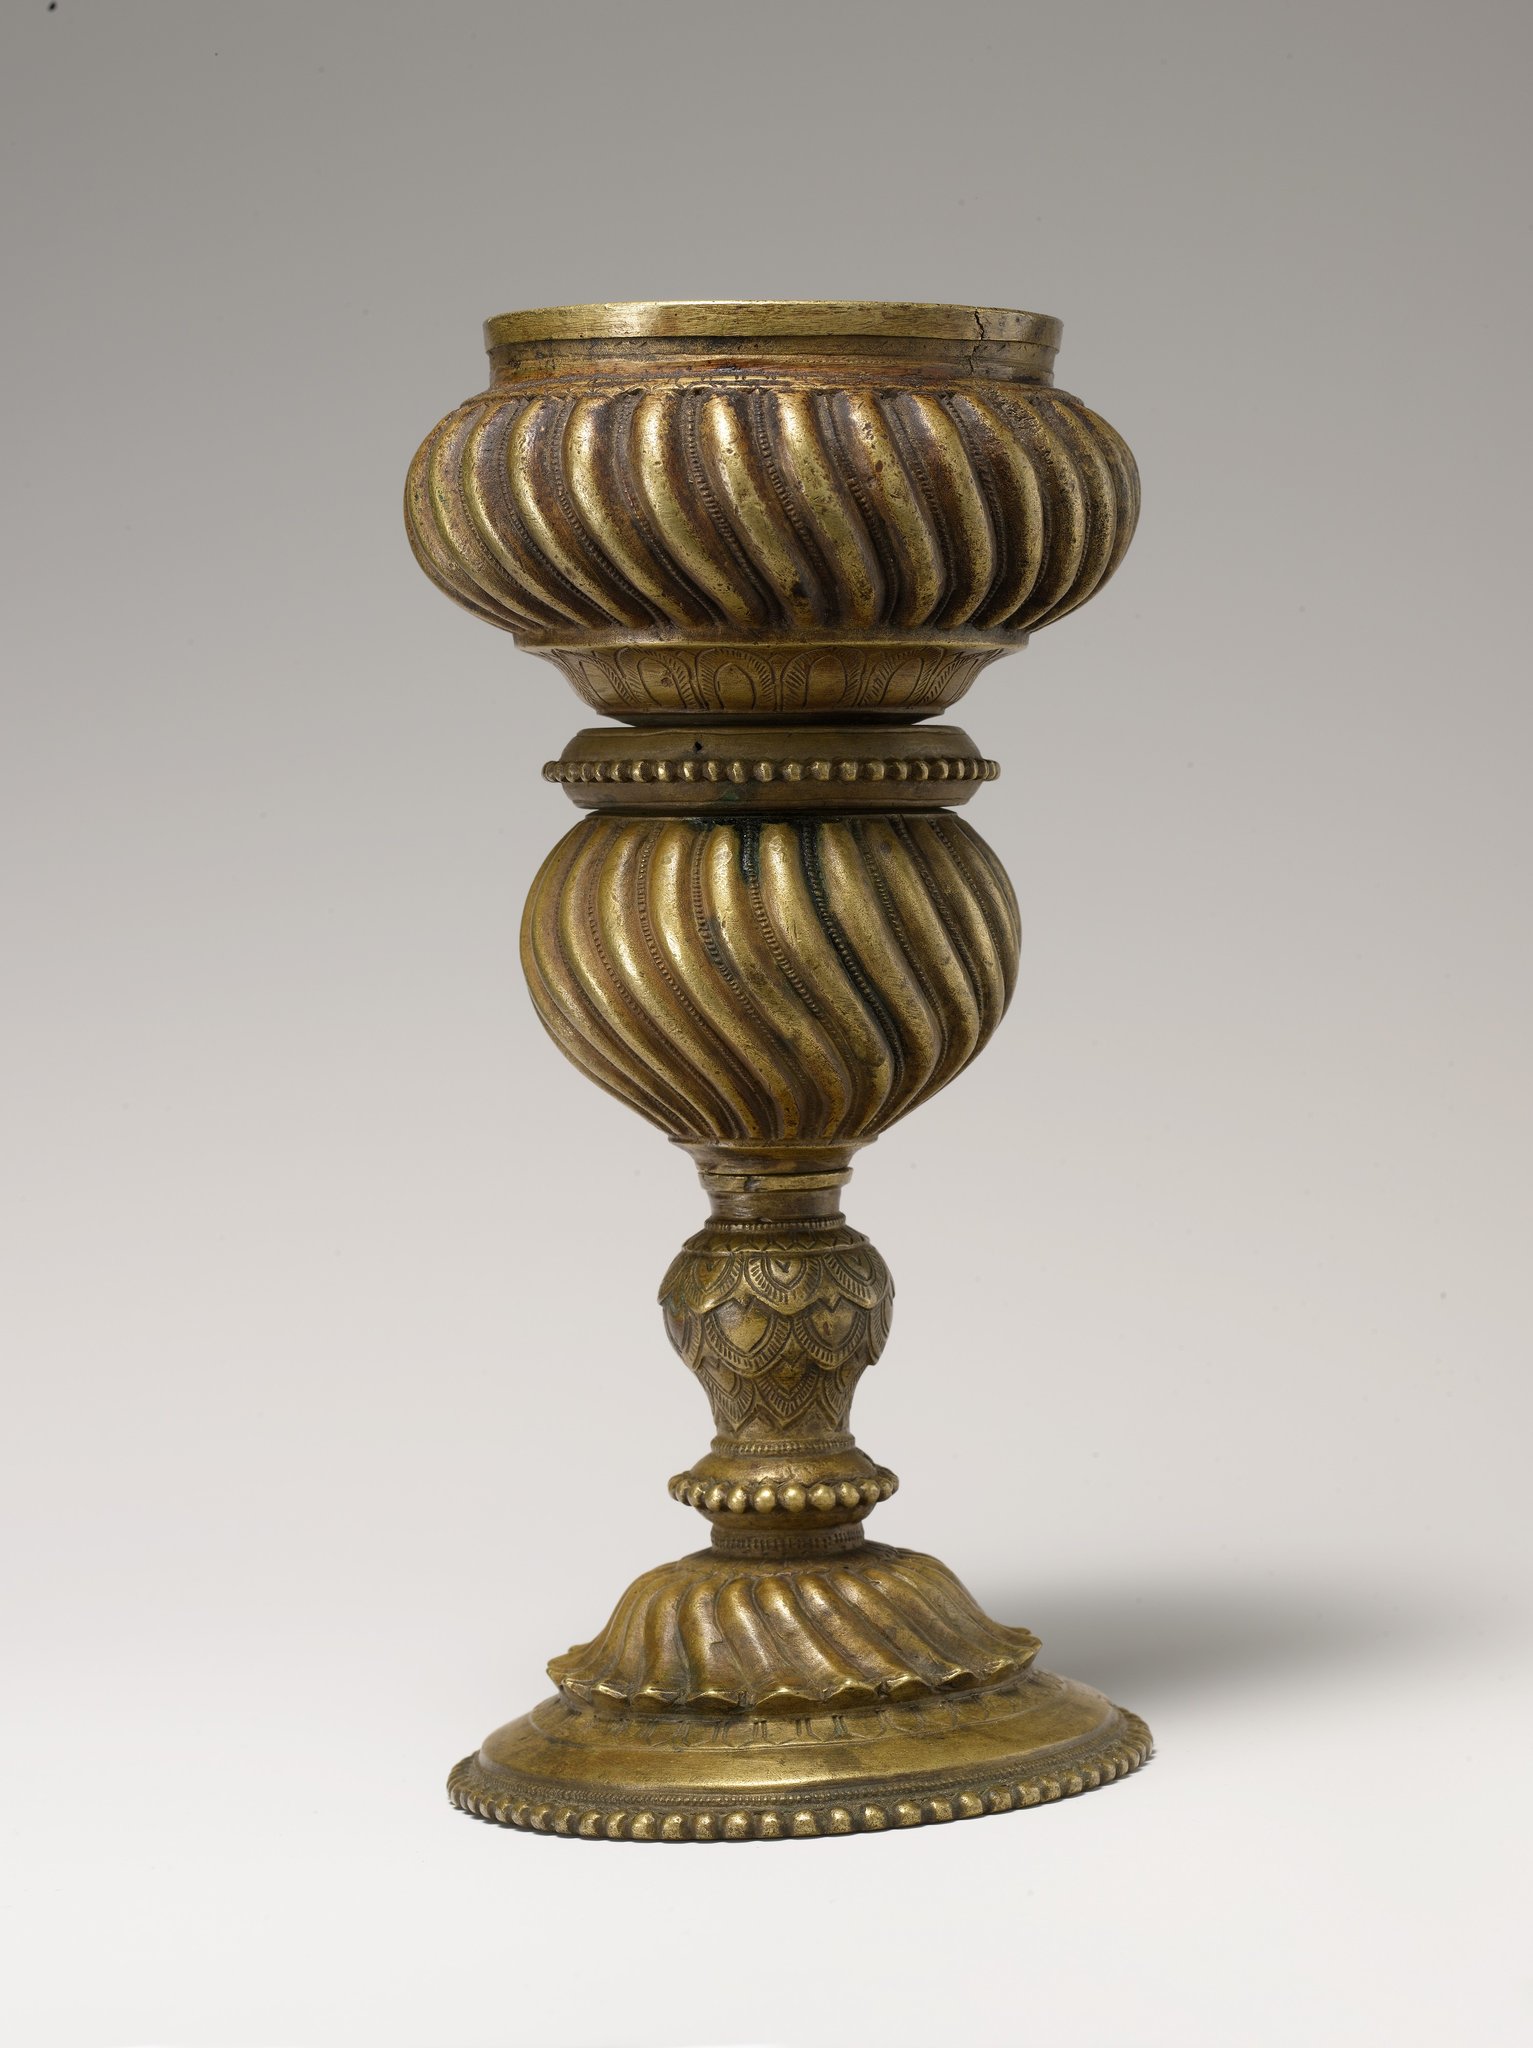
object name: spittoon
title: Spittoon or Incense Burner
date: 1567-1633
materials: brass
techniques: casting, engraving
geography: india